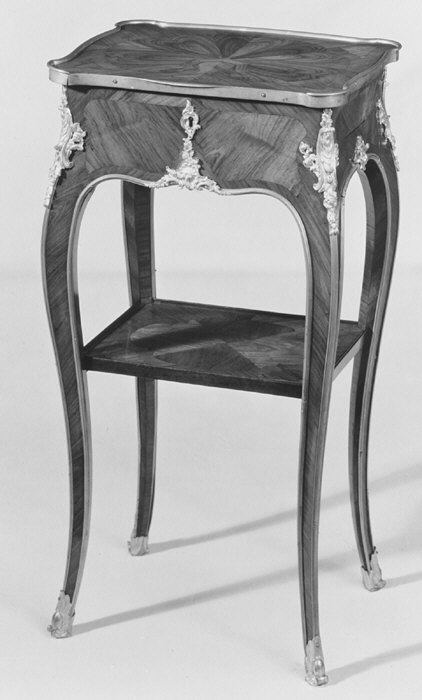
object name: work and writing table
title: Work and writing table (table en chiffonière)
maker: bernard ii van risenburgh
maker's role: maker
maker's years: 1696-1767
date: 1760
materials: wood, gilt bronze, silk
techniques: veneering